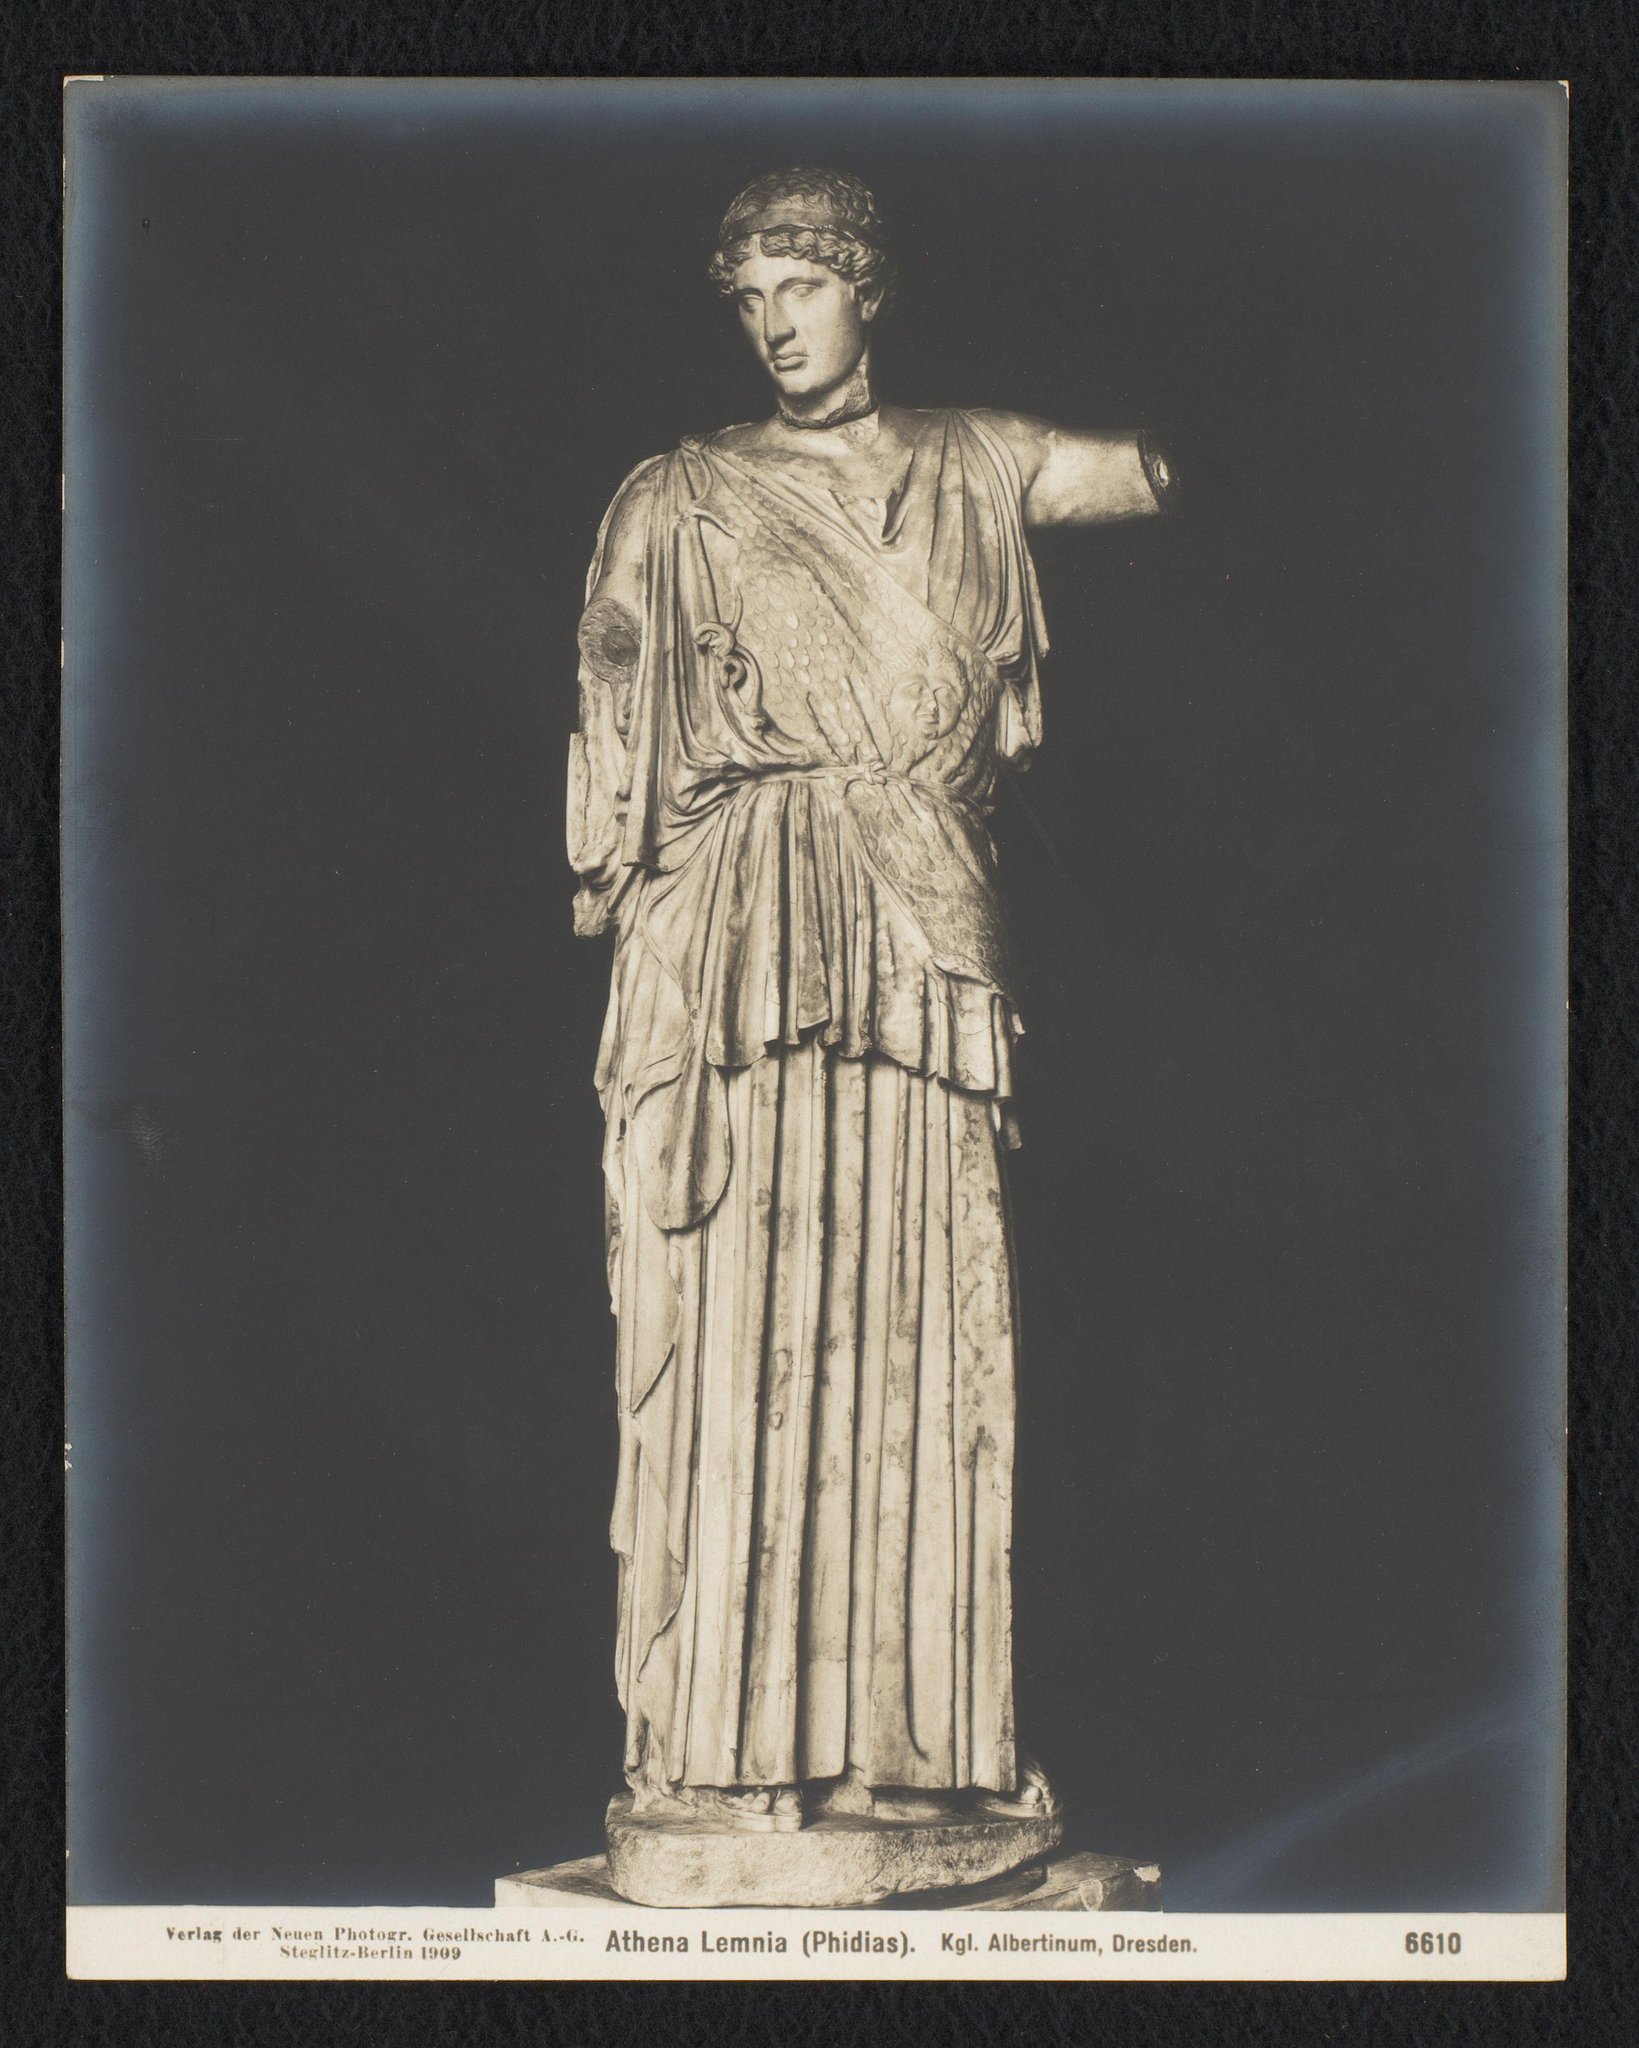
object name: photograph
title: Athena Lemnia door Phidias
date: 1906-1911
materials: paper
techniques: gelatin silver print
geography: steglitz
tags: sculpture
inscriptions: number: ‘6610’